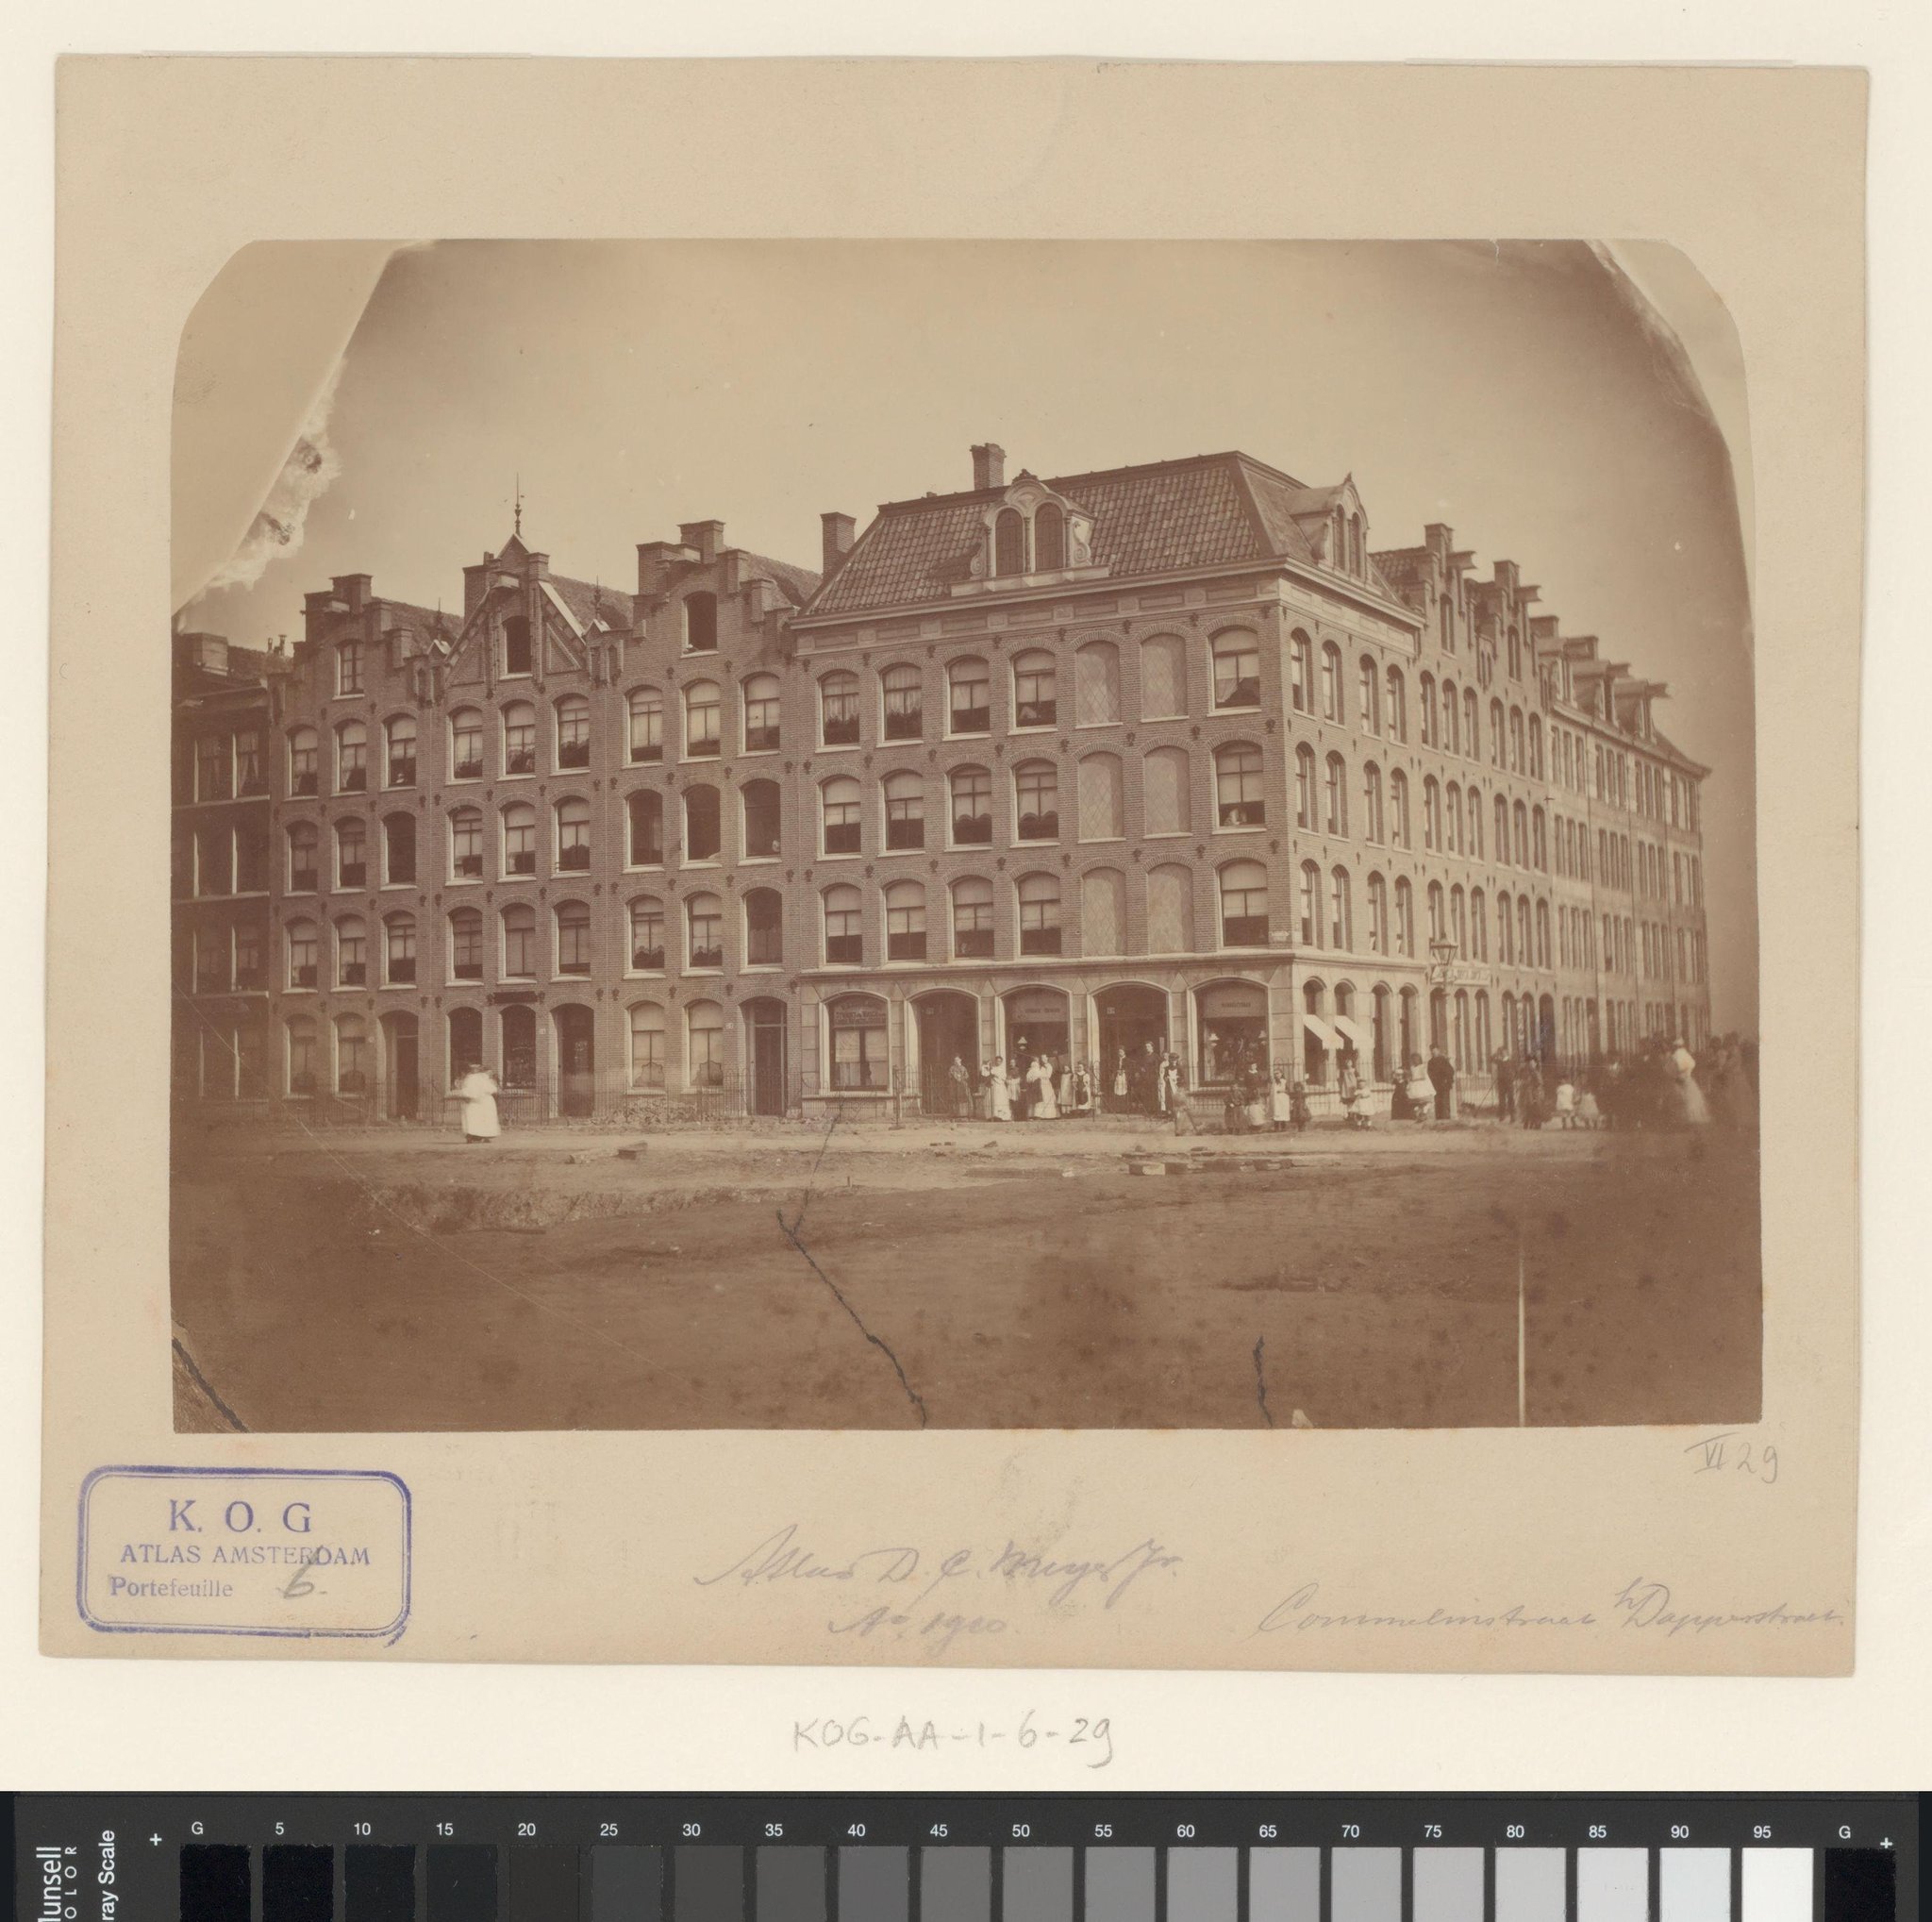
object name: photograph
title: Gezicht op de Commelinstraat, hoek Dapperstraat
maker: Anonymous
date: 1878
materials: paper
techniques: gelatin silver print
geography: amsterdam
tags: city-view in general; 'veduta', the usual house or row of houses, street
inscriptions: collector's mark: ‘6’ Lugt 1641b, inscription: ‘[...]ot[..]cafe / Commelinstraat 93 / hoek Dapperstr / en / Commelinstr / 1878’, inscription: ‘Atlas D.C. Meijer Jr. / Ao 1910 / Commelinstraat h Dapperstraat’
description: Onderwerpsrubriek binnen de Atlas Amsterdam: Buijskade, Catskade (Jacob), Clercqstraat (de), Commelinstraat, Costakade (da), Cuypstraat (Albert), Czaar Peterstraat.